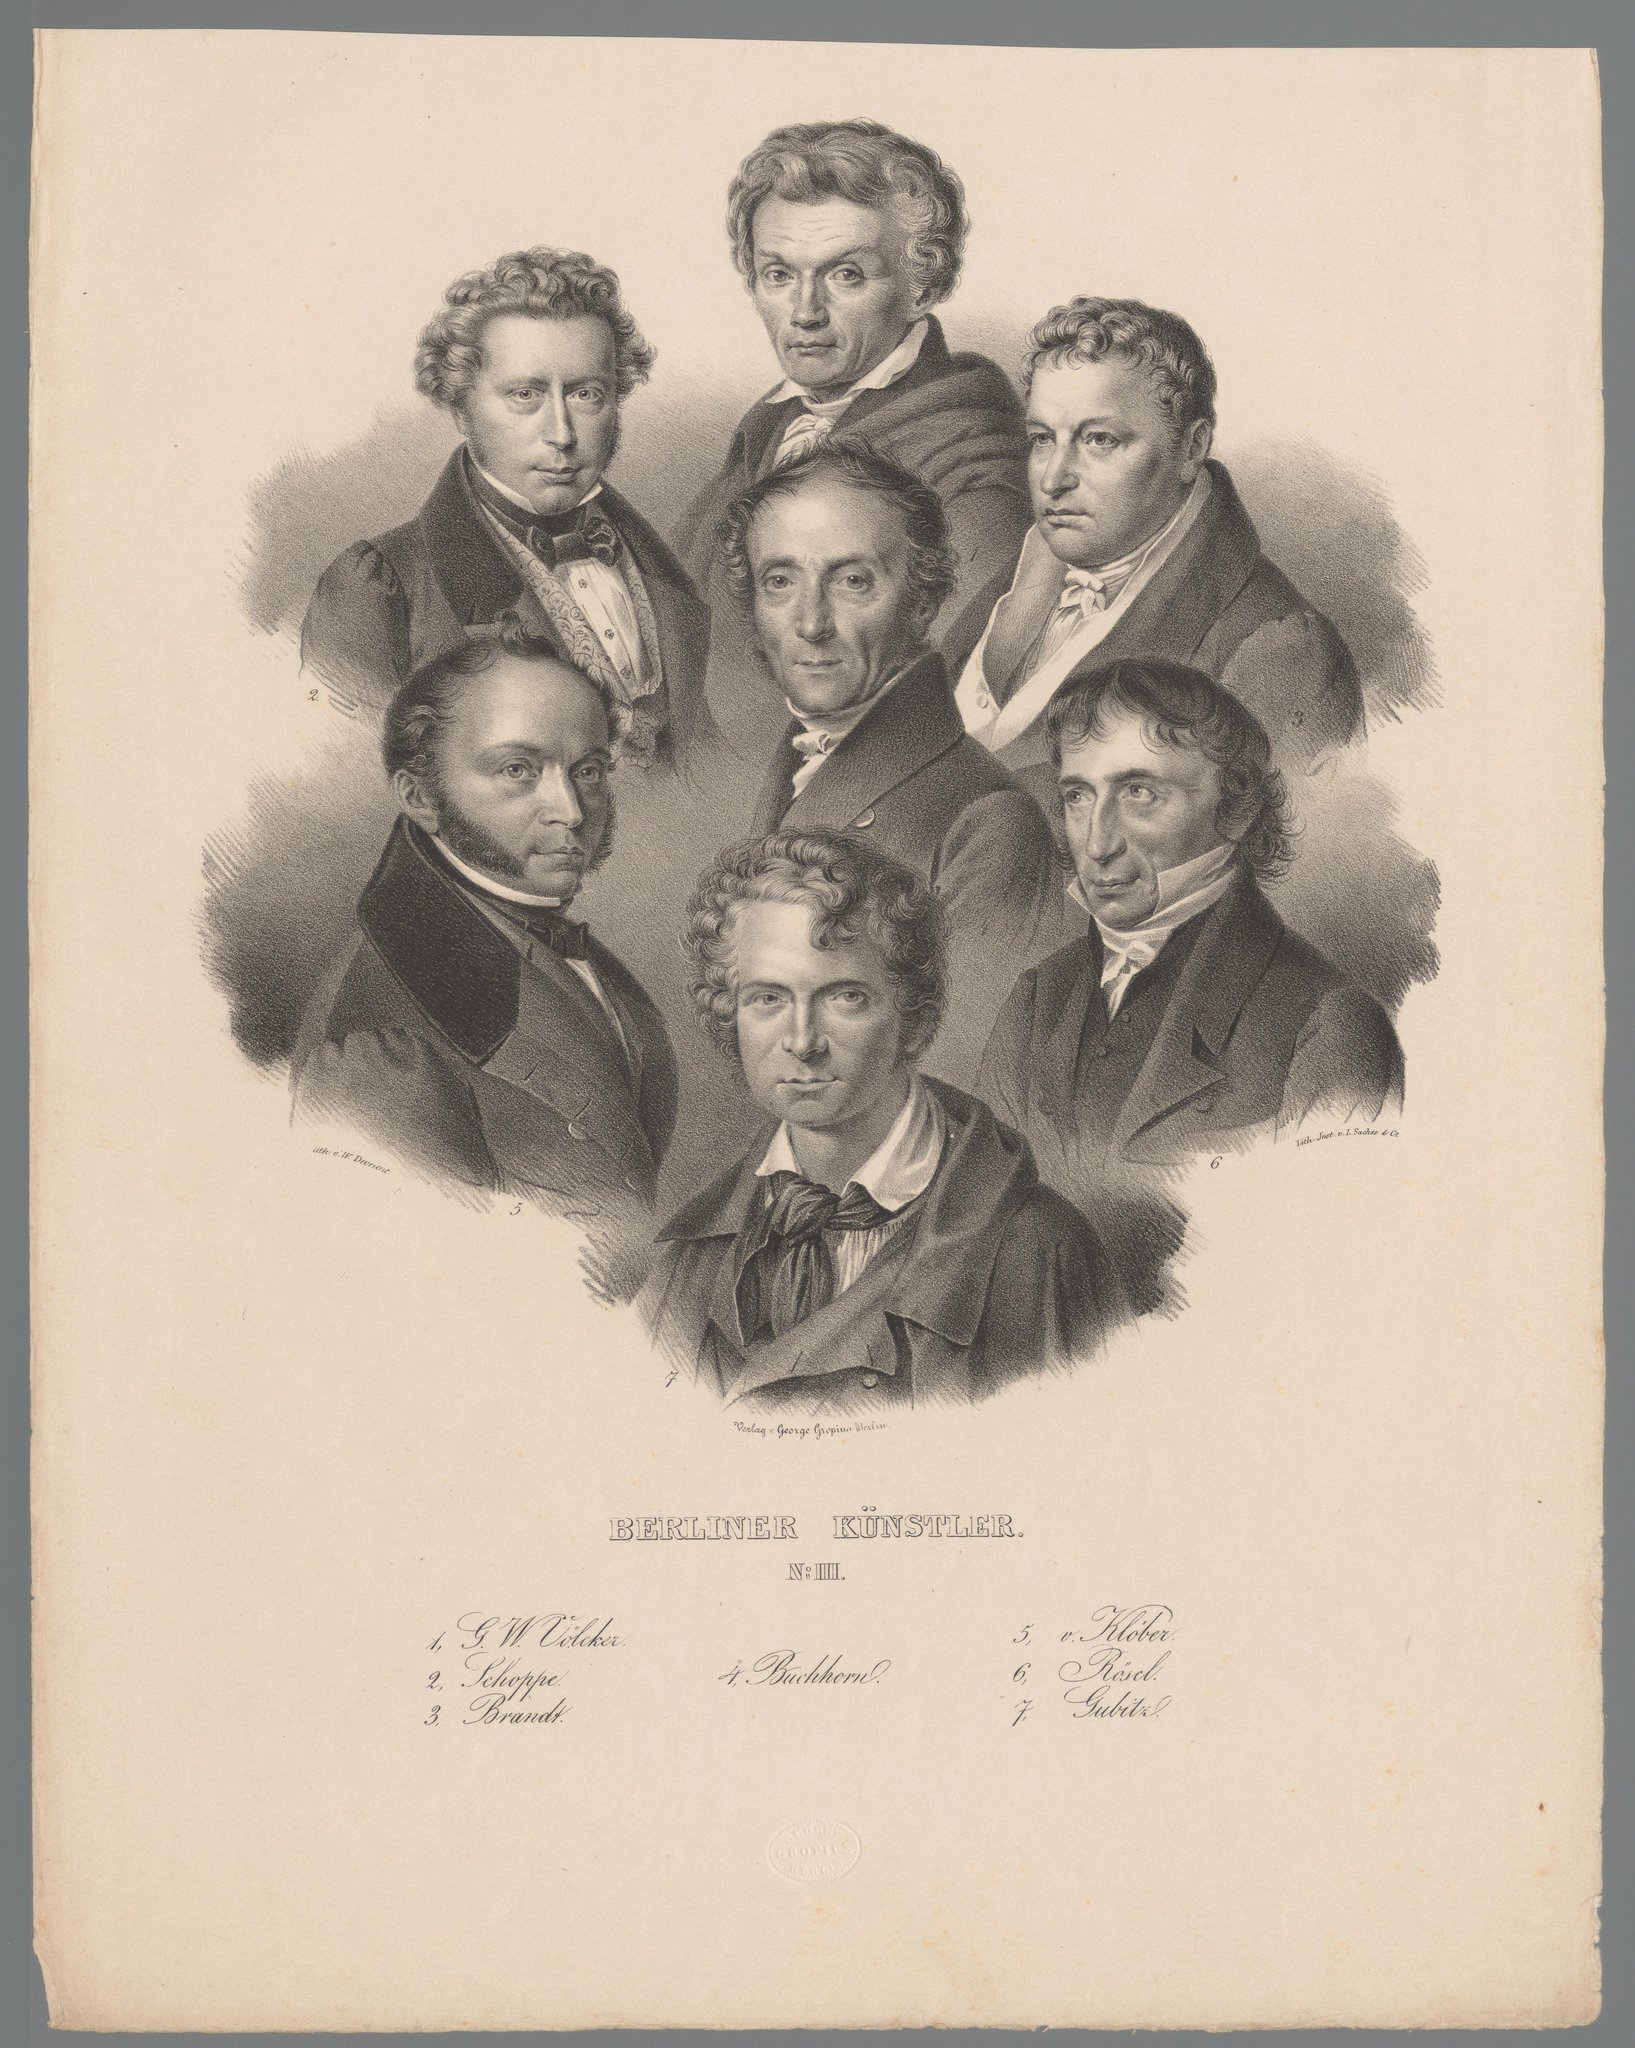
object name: print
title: Portretten van zeven Berlijnse kunstenaars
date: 1832-1842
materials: paper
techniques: lithograph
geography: berlin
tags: painter, ludwig buchhorn, printer, publisher, friedrich wilhelm gubitz, berlin, print maker, julius schoppe (i), henri-françois brandt, historical persons, portrait, self-portrait of artist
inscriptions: check stamp: Lugt 4607, collector's mark: Lugt 2228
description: Portretten van Ludwig Buchhorn, Gottfried Wilhelm Völcker, Julius (I) Schoppe, Henri-François Brandt, August von Klöber, Gottlob Samuel Roesel, en van Friedrich Wilhelm Gubitz.